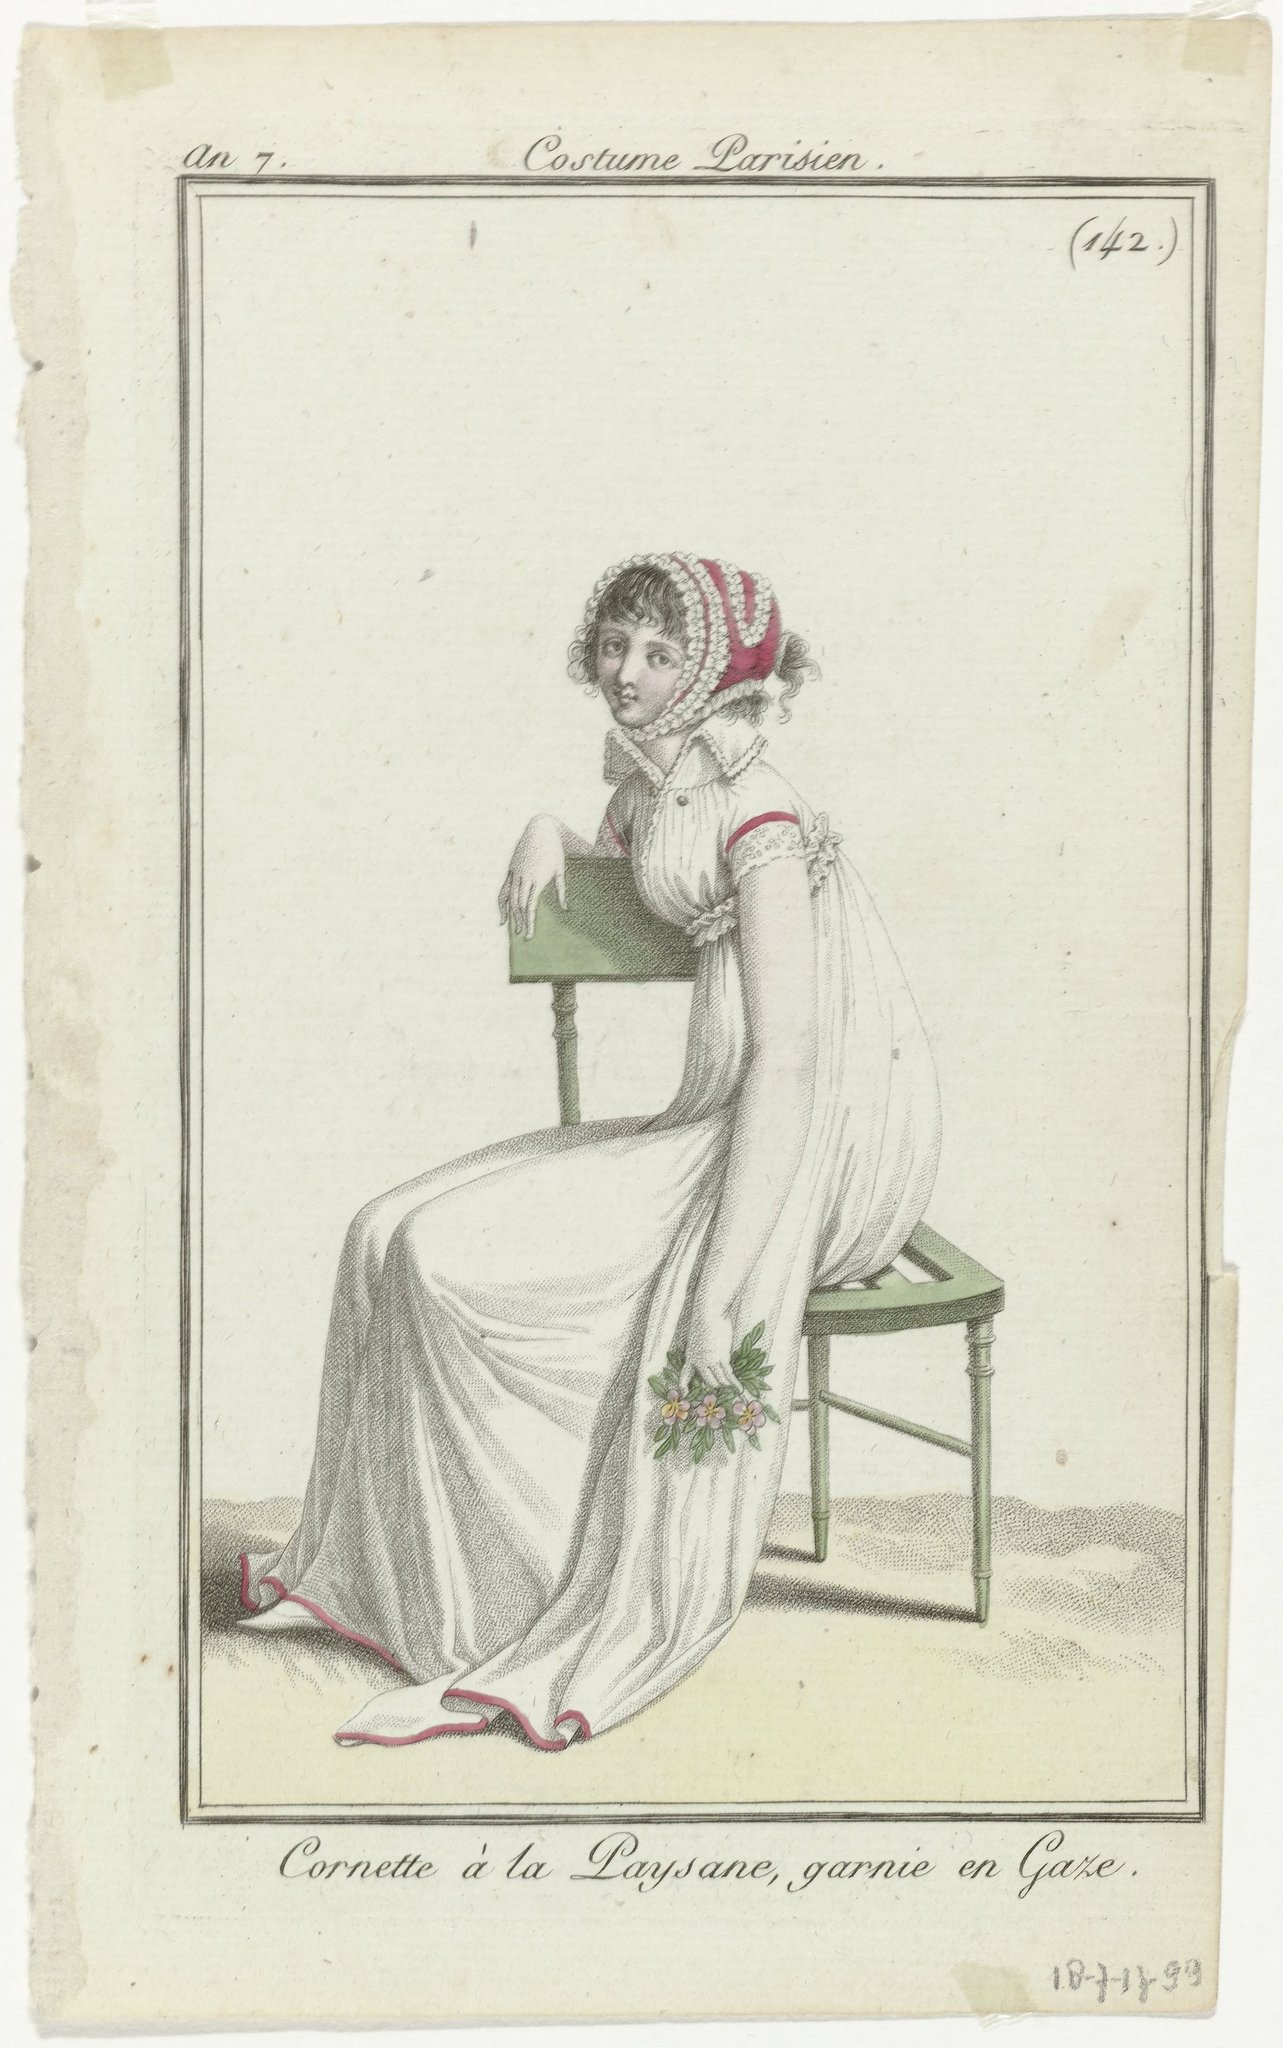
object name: fashion print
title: Journal des Dames et des Modes, Costume Parisien, 18 juillet 1799, An 7, (142.) : Cornette à la Paysan (...)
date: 1799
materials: paper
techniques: hand coloring, engraving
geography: paris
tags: cut flowers; nosegay, bunch of flowers, clothing for the upper part of the body: blouse (+ women's clothes), head-gear (cornette) (+ women's clothes), fashion plates, shoes, sandals (+ women's clothes), dress, gown (+ women's clothes), chair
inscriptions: title: ‘Costume Parisien.’, caption: ‘Cornette à la Paysane, garnie en Gaze.’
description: Vrouw, zittend op een stoel, met een ruikertje in de linkerhand. Op het hoofd een 'Cornette à la Paysane', afgezet met tule. Zij draagt een canezou op een japon met sleep. platte schoen met puntige neus. De prent maakt deel uit van het modetijdschrift Journal des Dames et des Modes, uitgegeven door Pierre de la Mésangère, Parijs, 1797-1839.